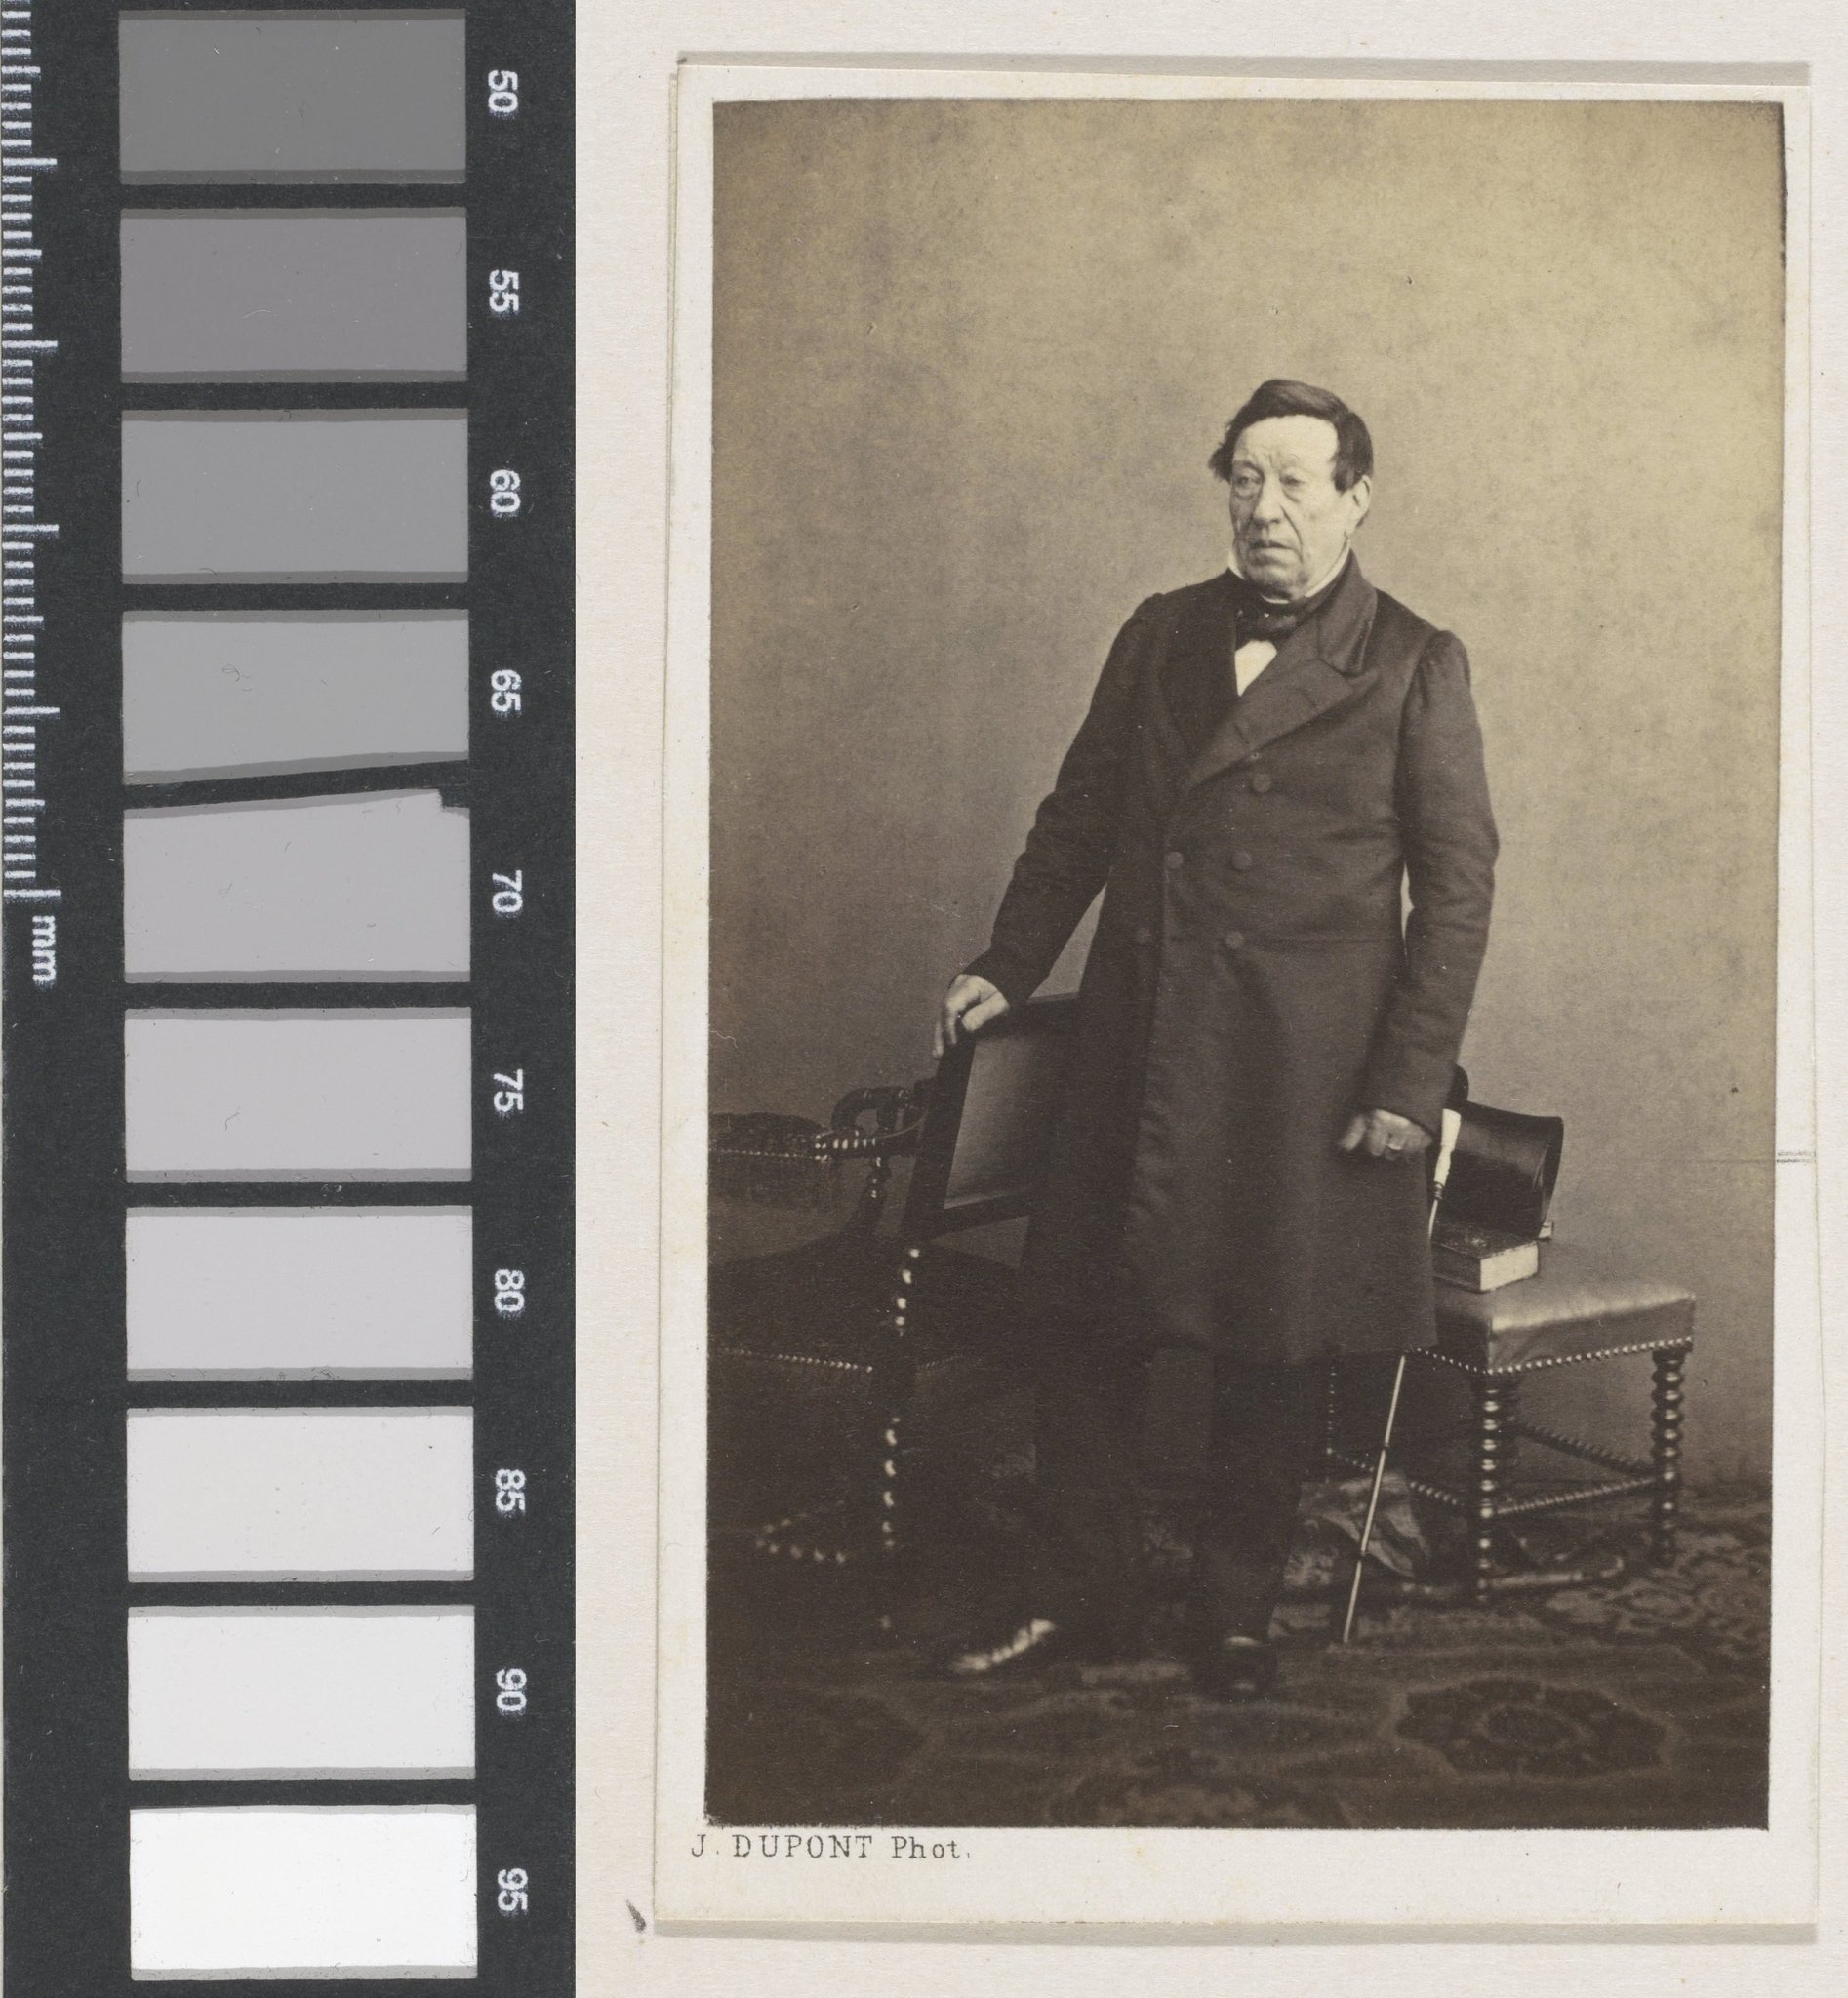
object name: photograph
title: L'École d'Anvers. Portraits biographies cartes de visite. Collection Dupont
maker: joseph dupont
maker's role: fotograaf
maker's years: 1818-1901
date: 1861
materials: cardboard, paper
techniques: albumen print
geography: antwerp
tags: antwerp, print maker, jean-baptiste van rooy, portrait, self-portrait of sculptor, historical persons, portrait, self-portrait of painter, portrait, self-portrait of artist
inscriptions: inscription: ‘ETABLISSEMENT PHOTOGRAPHIQUE/ de/ J. DUPONT/ Place de Meir 32/ ANVERS/ Maison fondée en 1853’